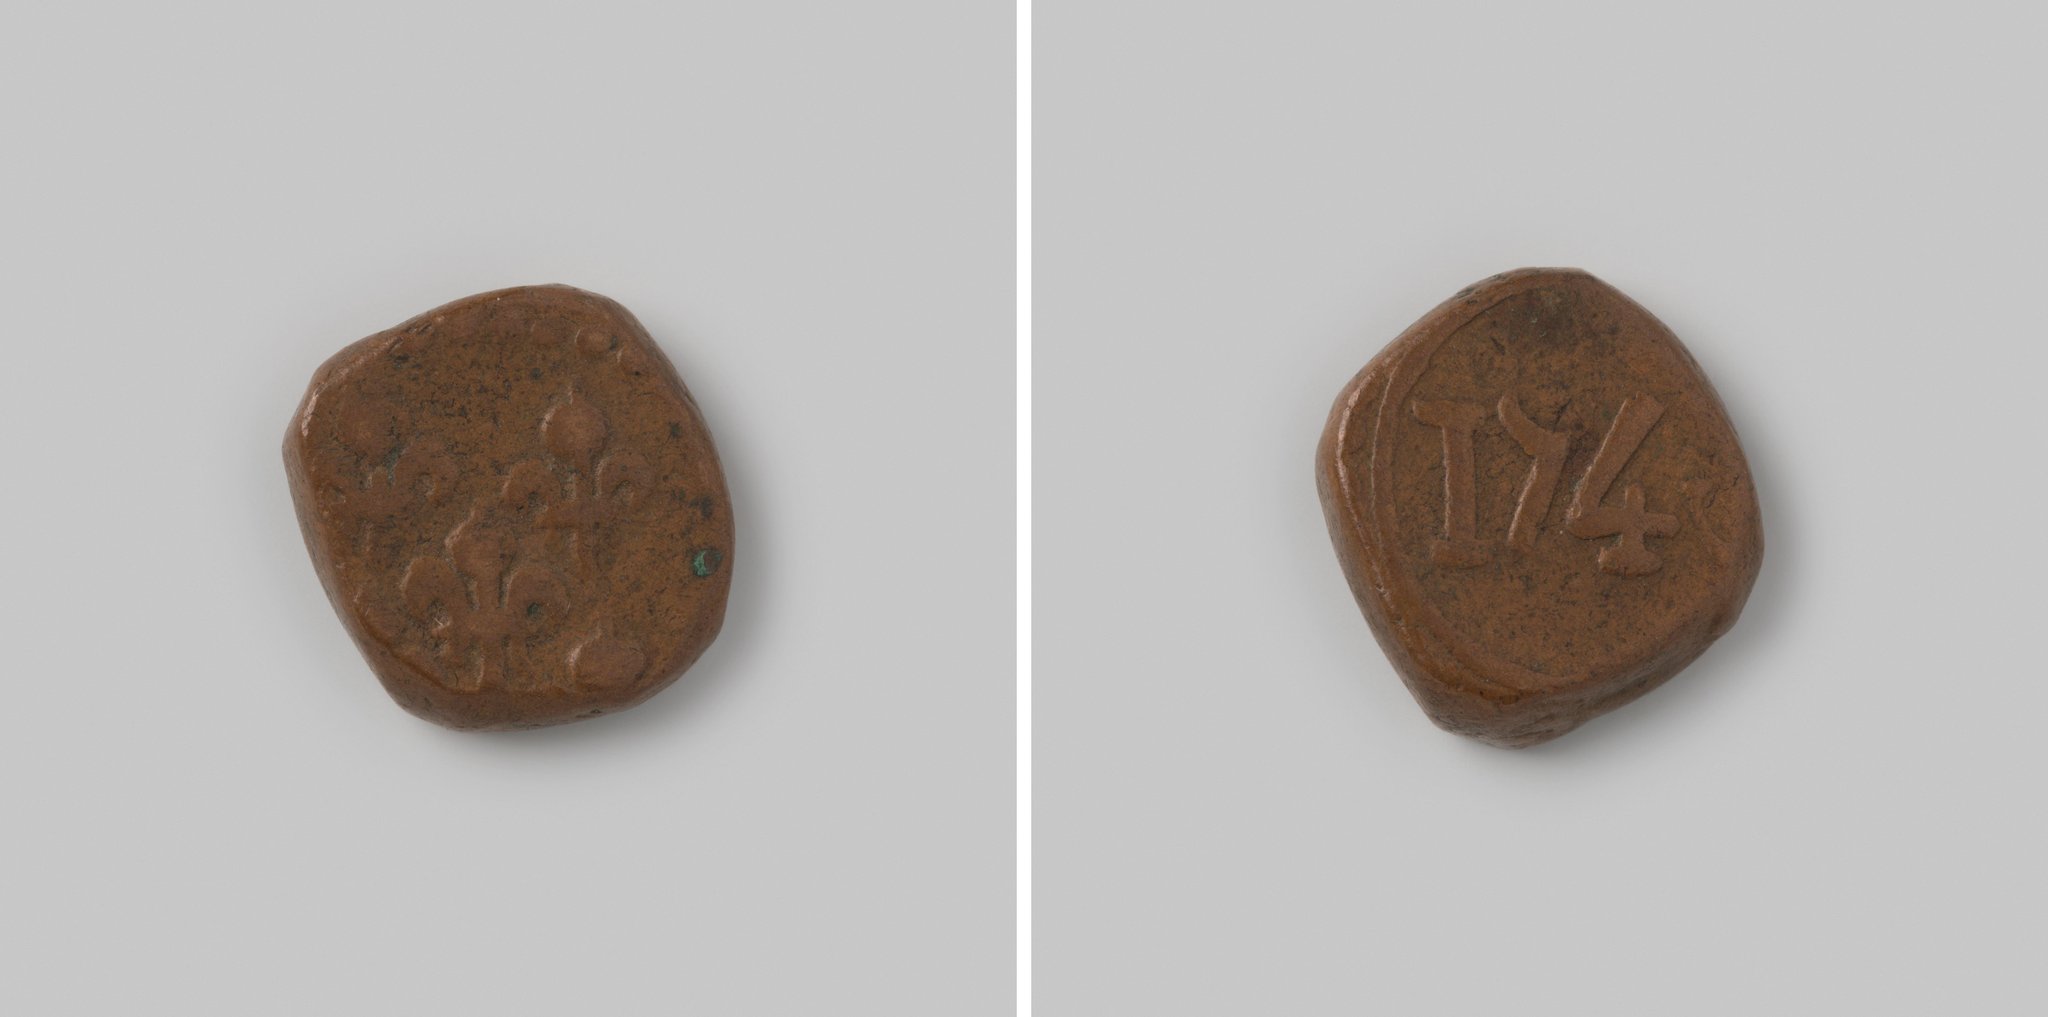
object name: coin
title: ½ biche uit Mahé in India van de Franse Compagnie perpétuelle des Indes,1743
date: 1743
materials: copper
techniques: striking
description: Koperen munt. Voorzijde: in drie rijen vijf lelies. Keerzijde: jaartal: 1745. Geslagen te Pondicherry.